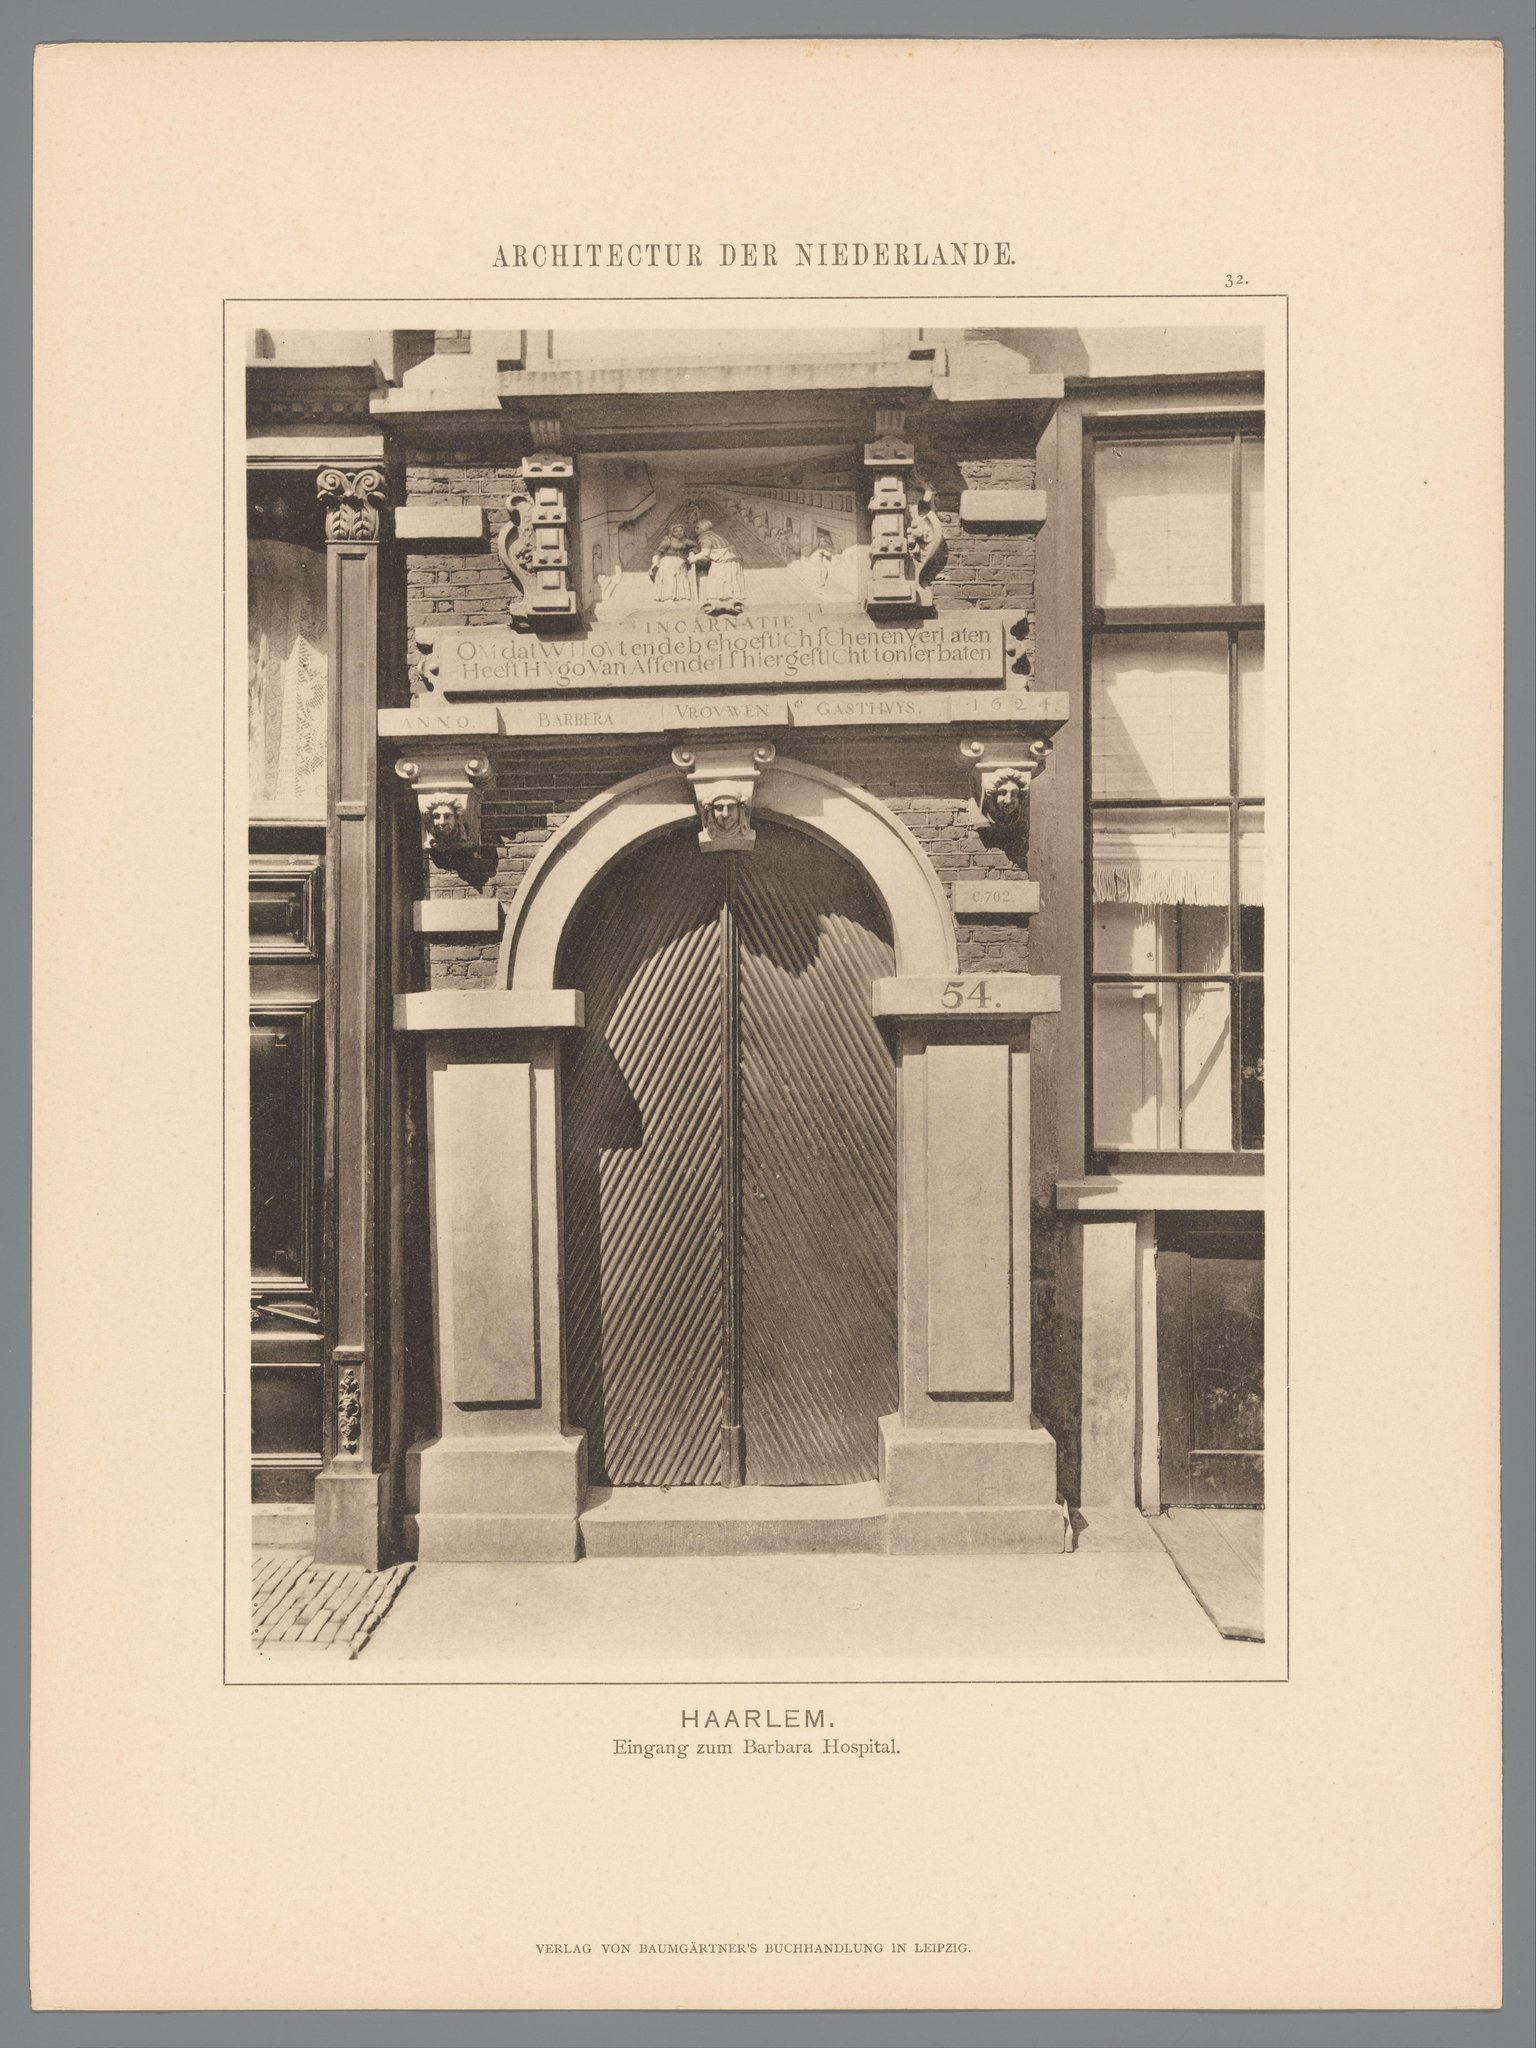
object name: book illustration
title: Gezicht op de ingang van het St. Barbara Gasthuis in Haarlem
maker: Anonymous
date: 1894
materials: paper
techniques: photograph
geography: leipzig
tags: alms-house (dutch: 'hofje'), gate, entrance, hospital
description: Afdruk uit: Krook, L. Architectur der Niederlande. Leipzig: Baumgärtner's Buchhandlung, 1894.